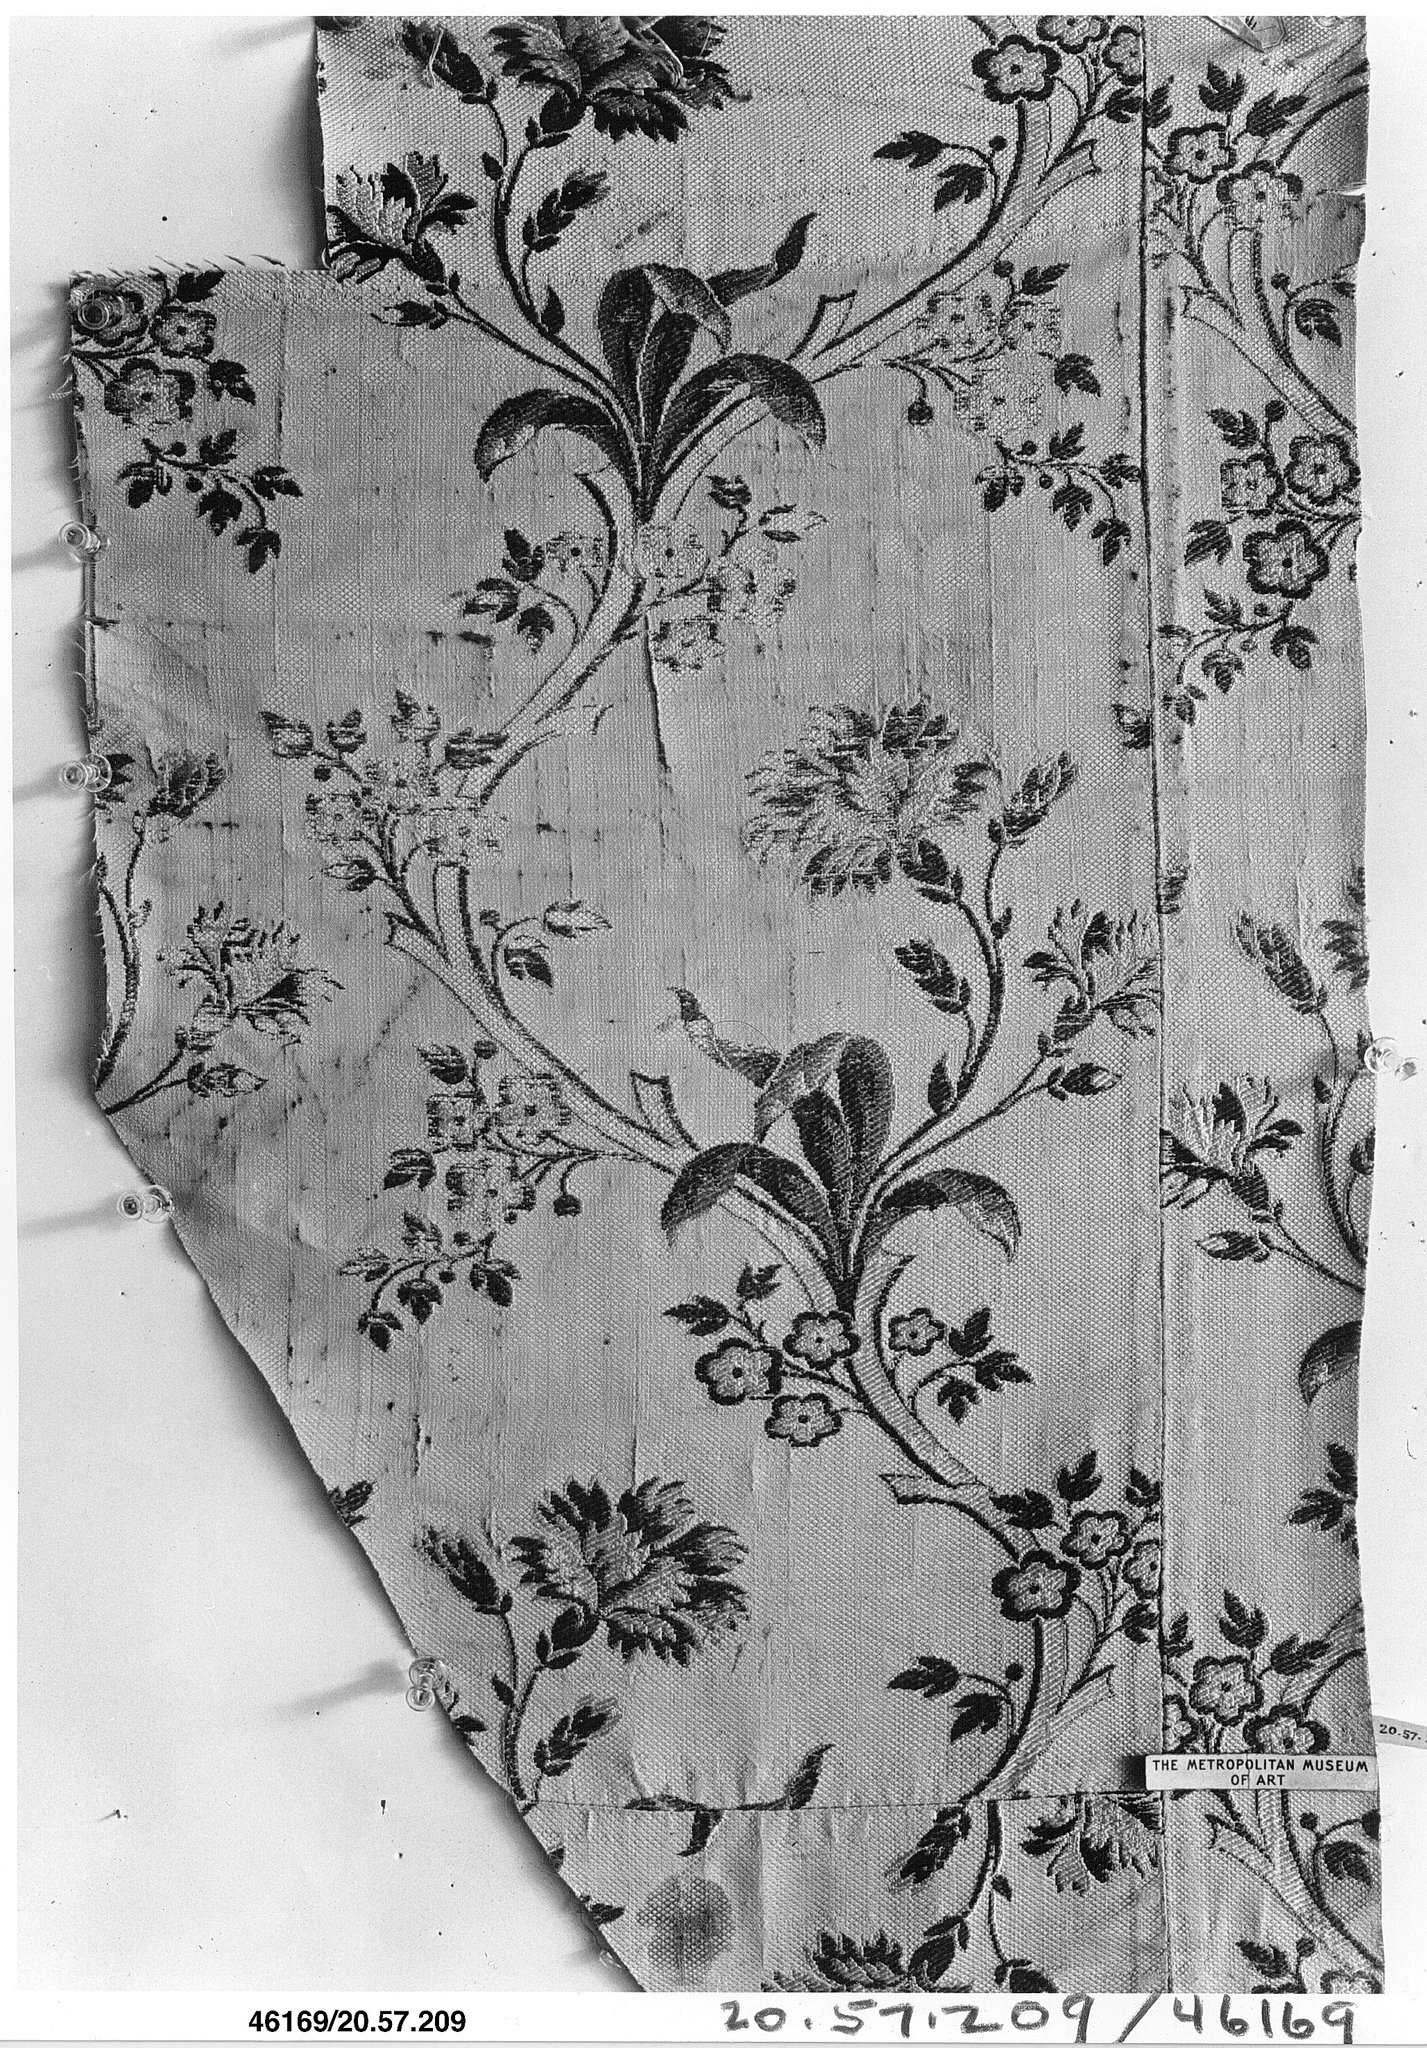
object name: piece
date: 1750-1760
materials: silk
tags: flowers,leaves